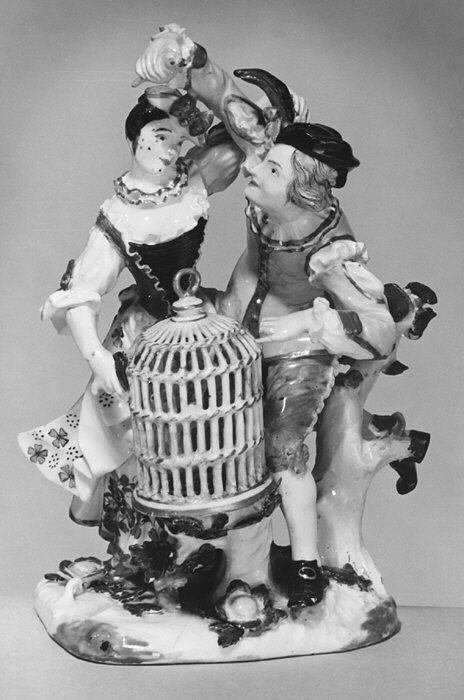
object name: group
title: Harlequin and Columbine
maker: meissen manufactory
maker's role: manufactory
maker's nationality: german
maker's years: 1710-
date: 1741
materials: hard paste porcelain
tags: men,women,dancing